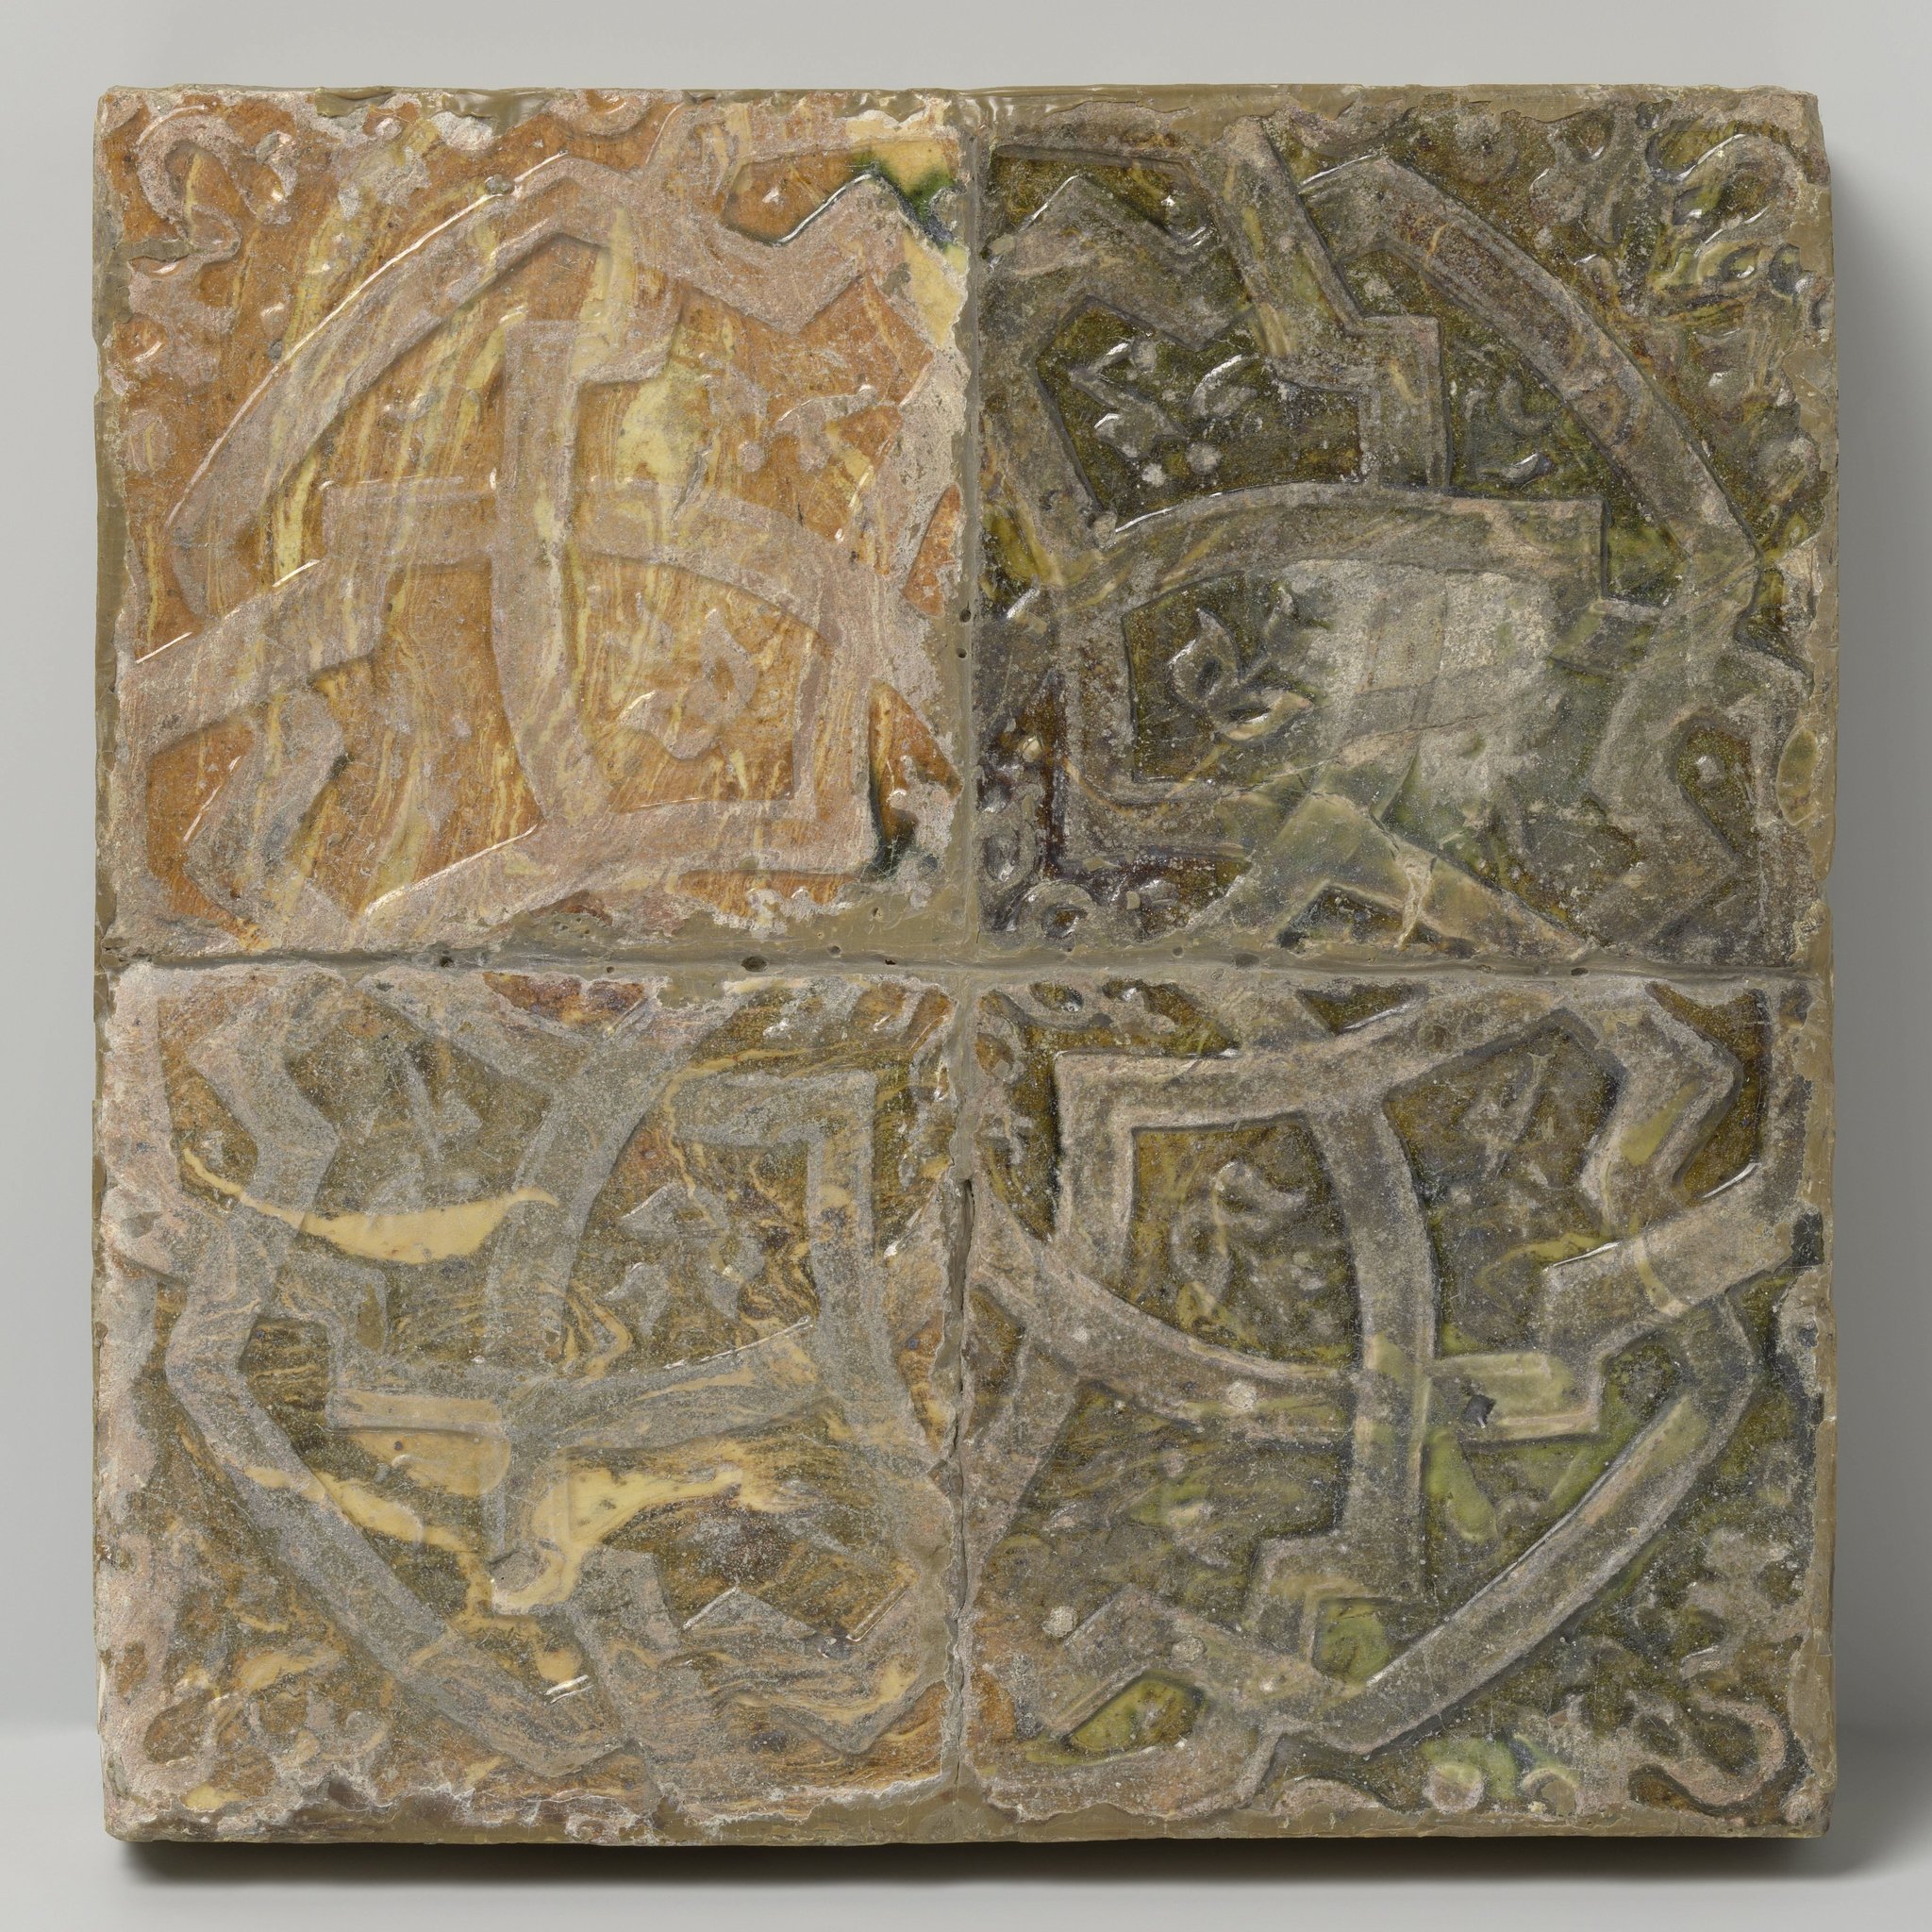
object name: floor tile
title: Veld van vier tegels die gezamenlijk een ster vormen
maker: Anonymous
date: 1500-1550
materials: earthenware, glaze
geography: netherlands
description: Vier tegels (2 x 2) die samen een ster vormen.